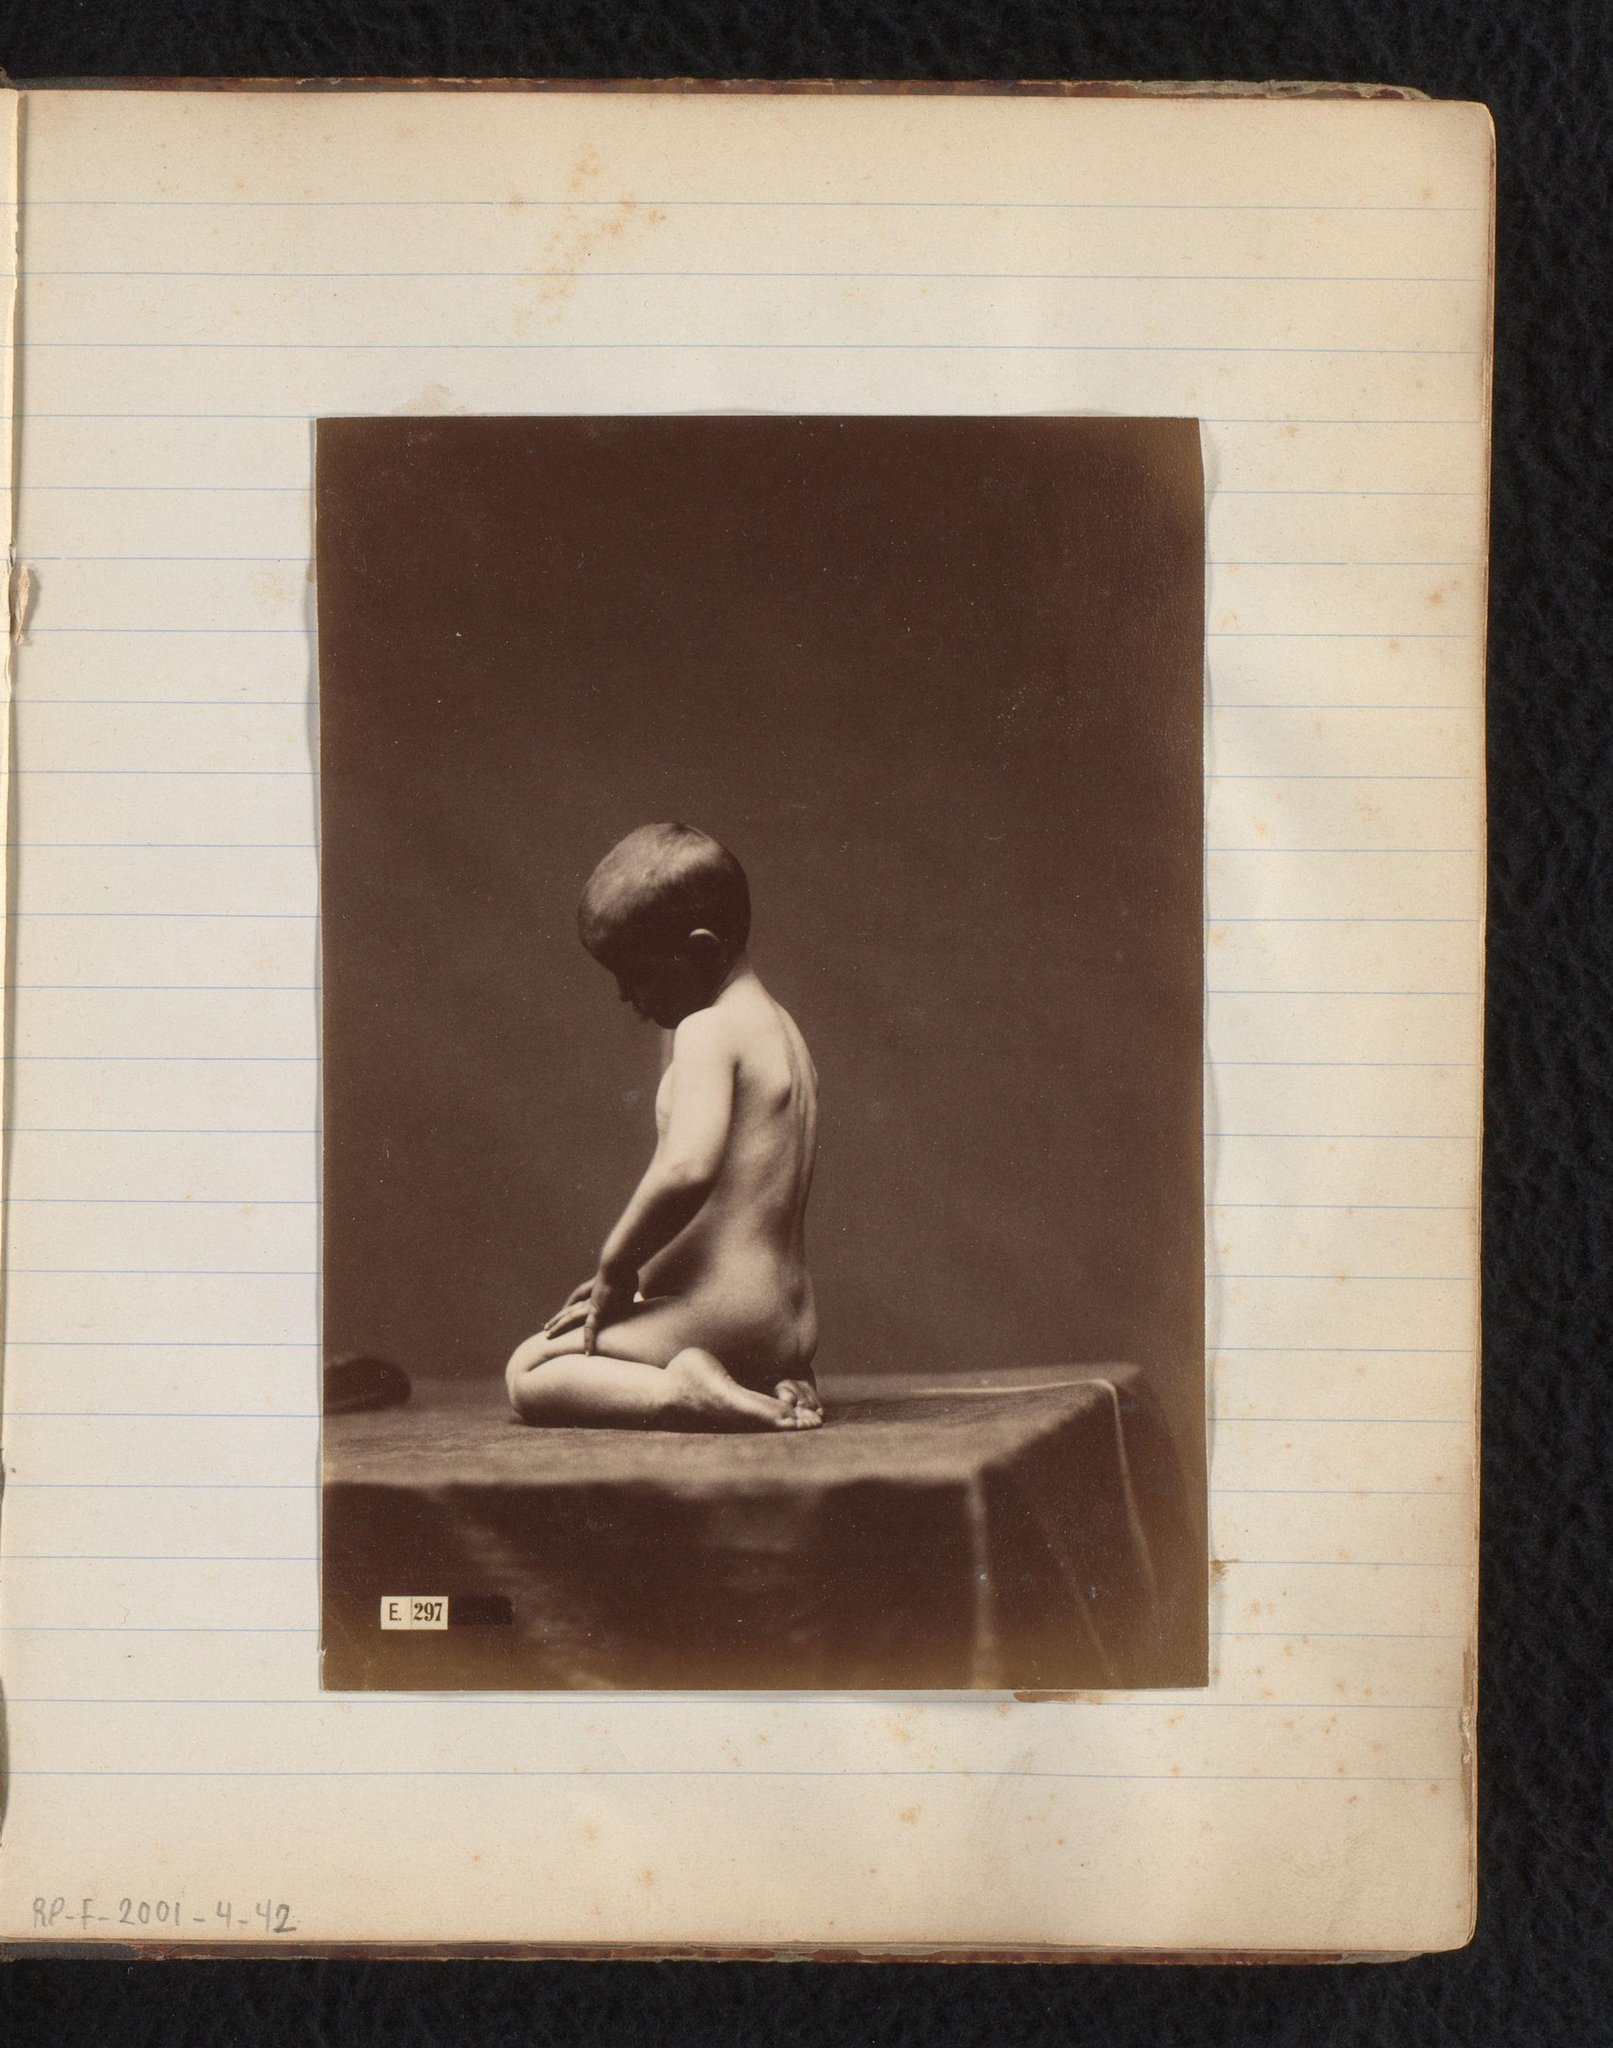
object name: photograph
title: Studie van een naakt kind op de knieën gezeten en van opzij gezien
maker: louis jean-baptiste igout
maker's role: fotograaf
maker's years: 1837-1881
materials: photographic support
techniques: albumen print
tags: the (nude) human figure; 'corpo humano' (ripa) (+ sideview, profile), child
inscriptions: number: ‘E. 297.’